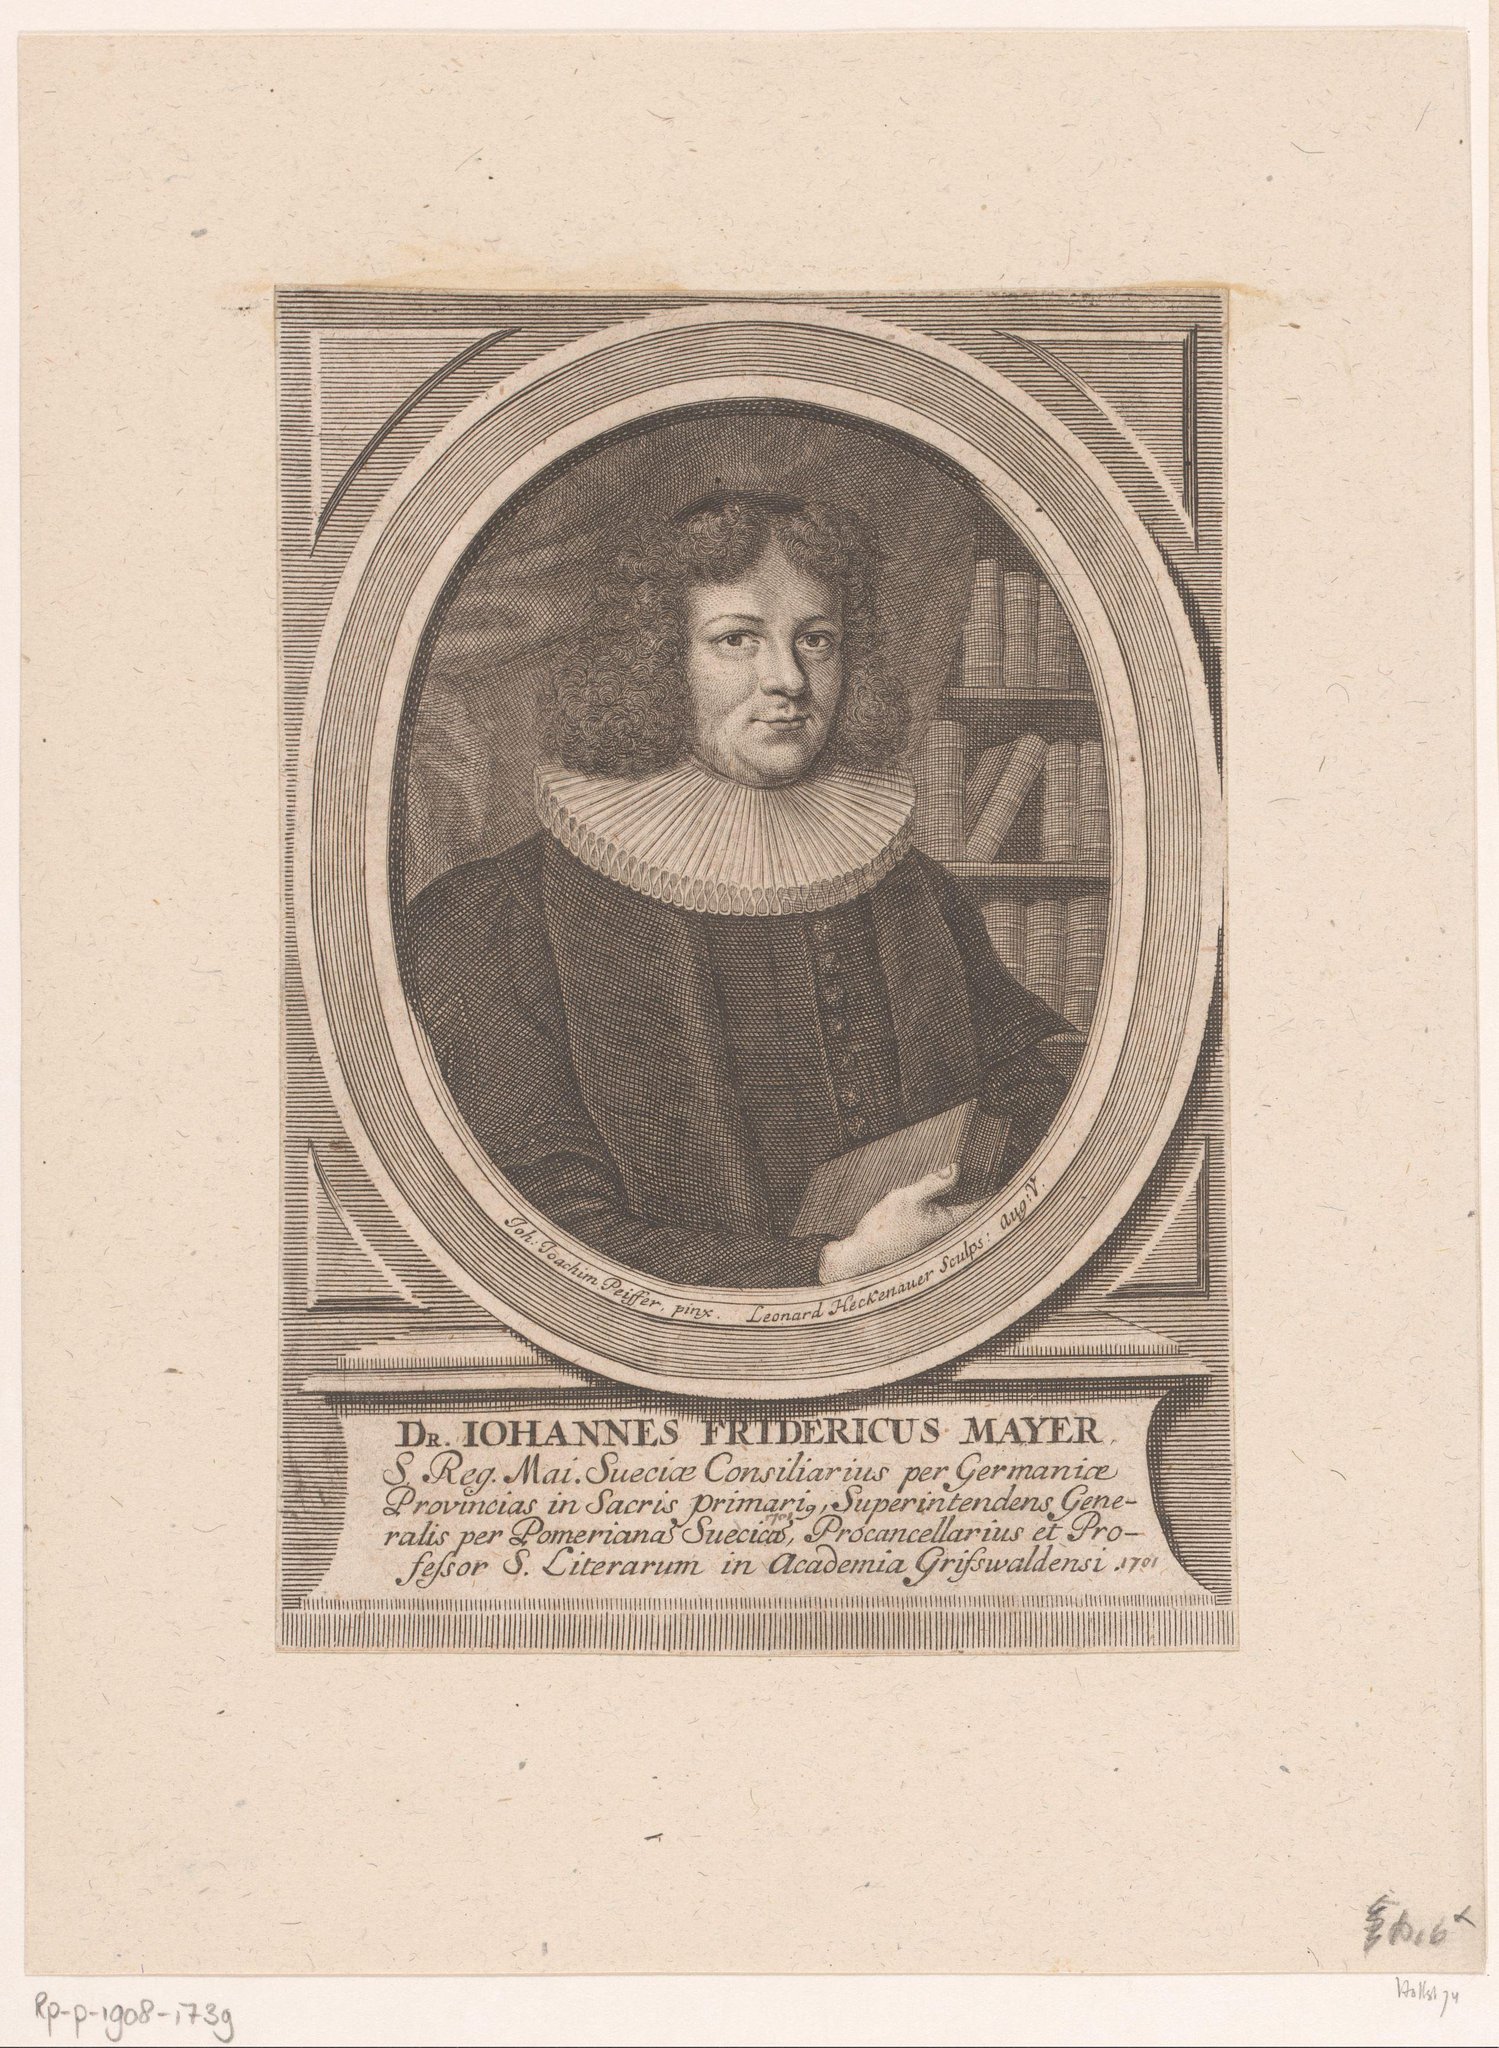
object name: print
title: Portret van Johann Friedrich Mayer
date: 1660-1704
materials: paper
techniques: engraving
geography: augsburg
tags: bookshelves, ornament ~ medallion, historical persons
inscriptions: collector's mark: Lugt 2228